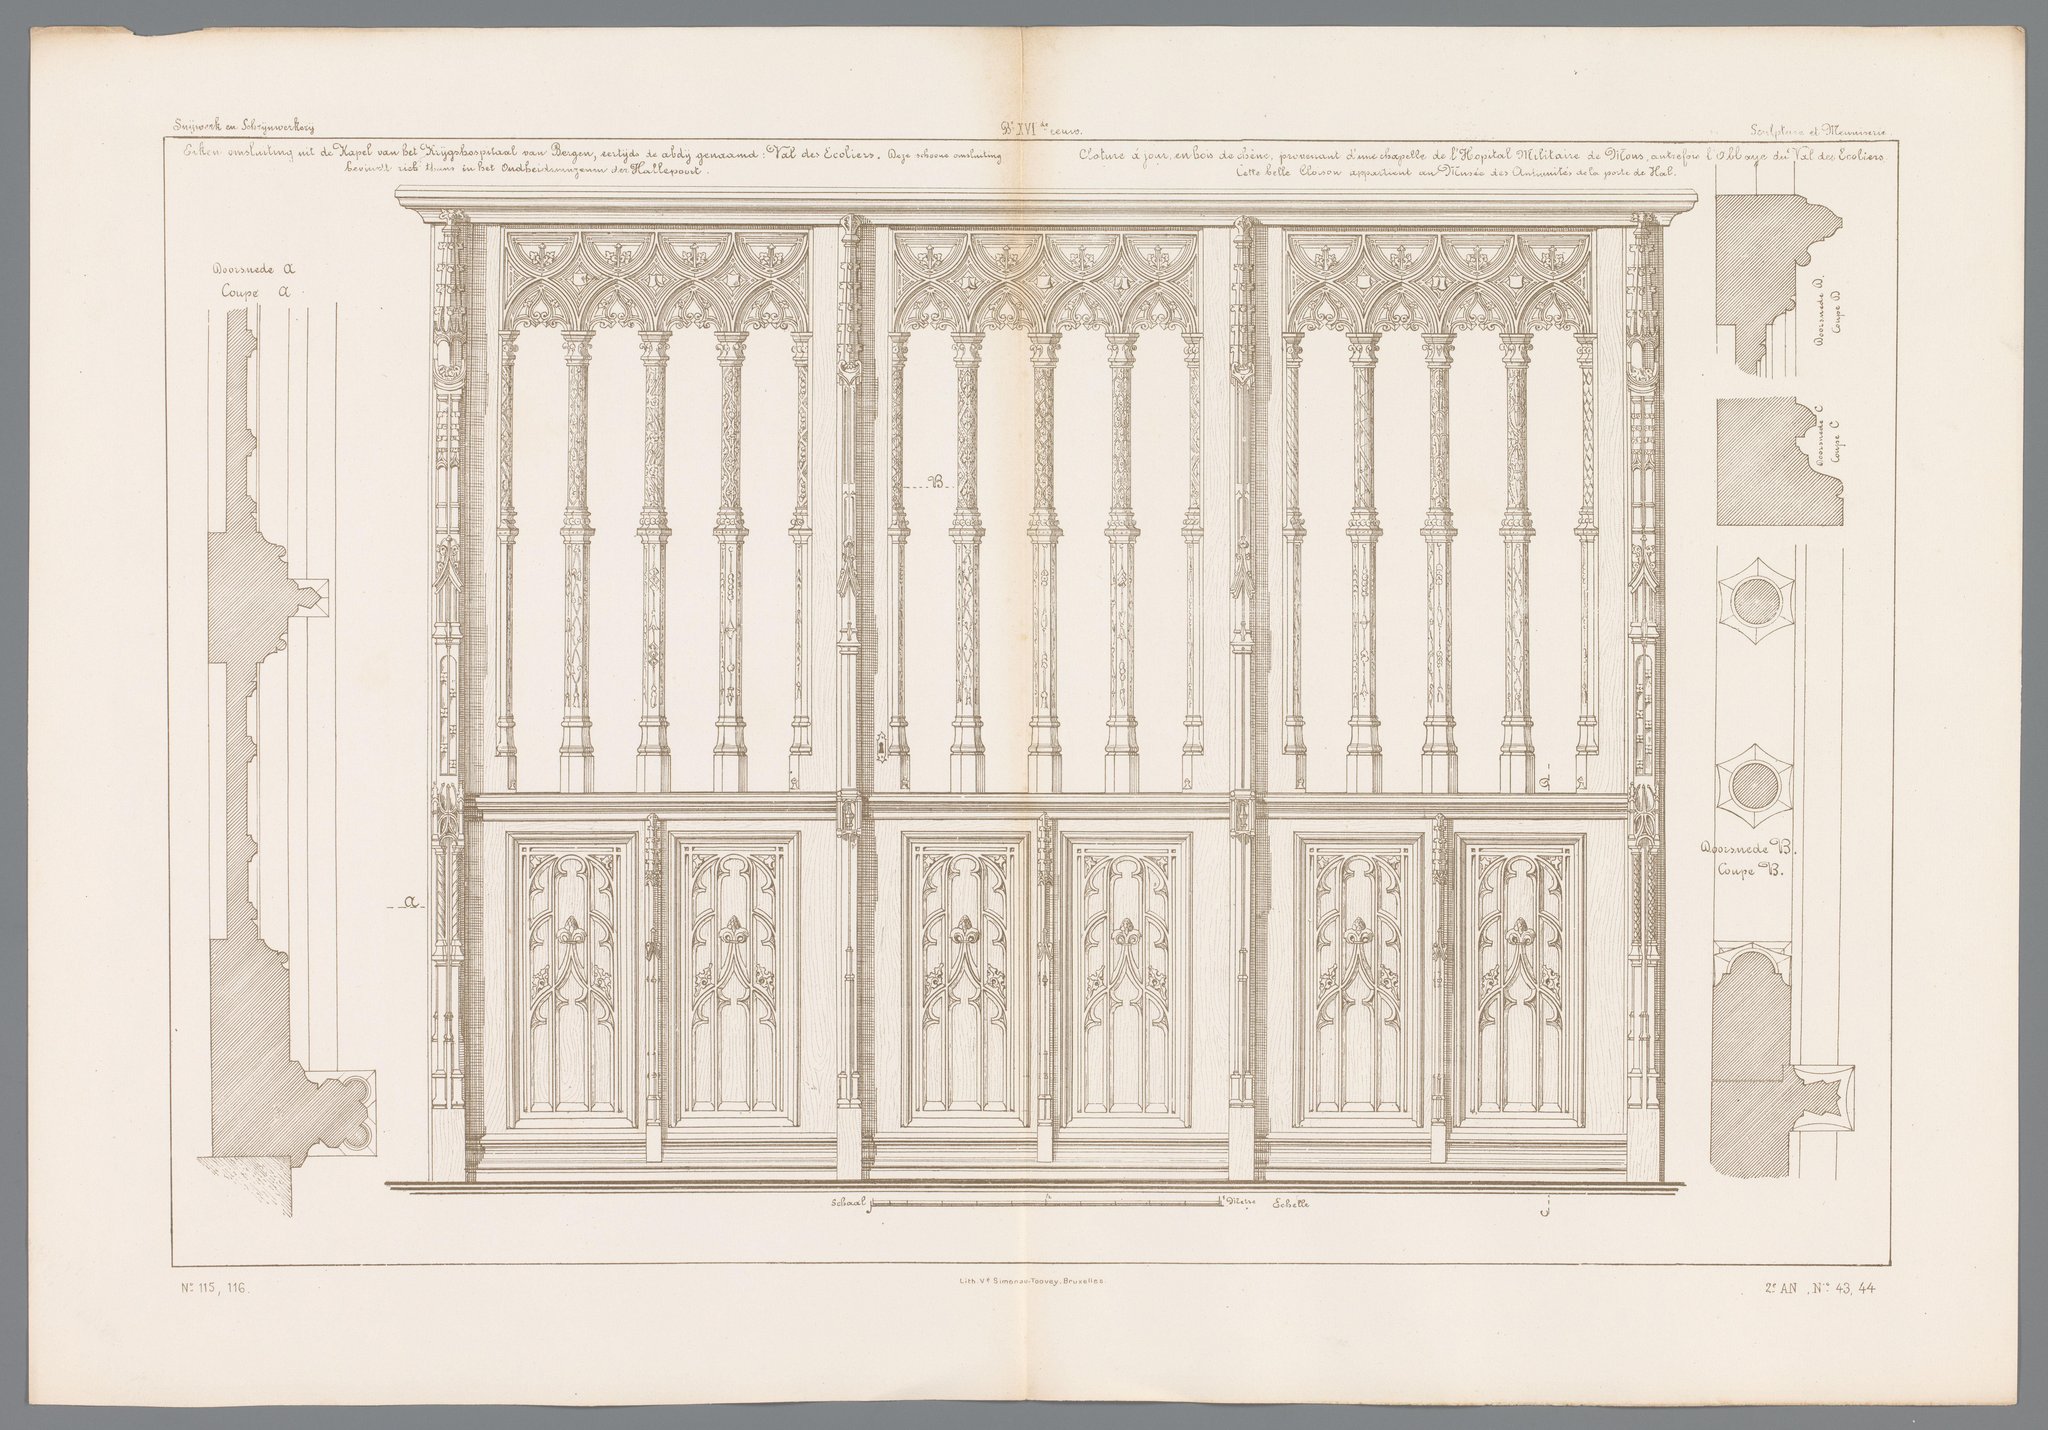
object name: print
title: Eiken omsluiting uit de Kapel van het Krijgshospitaal van Bergen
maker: Anonymous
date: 1870-1899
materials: paper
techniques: lithograph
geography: brussels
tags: parts of church interior: chapel